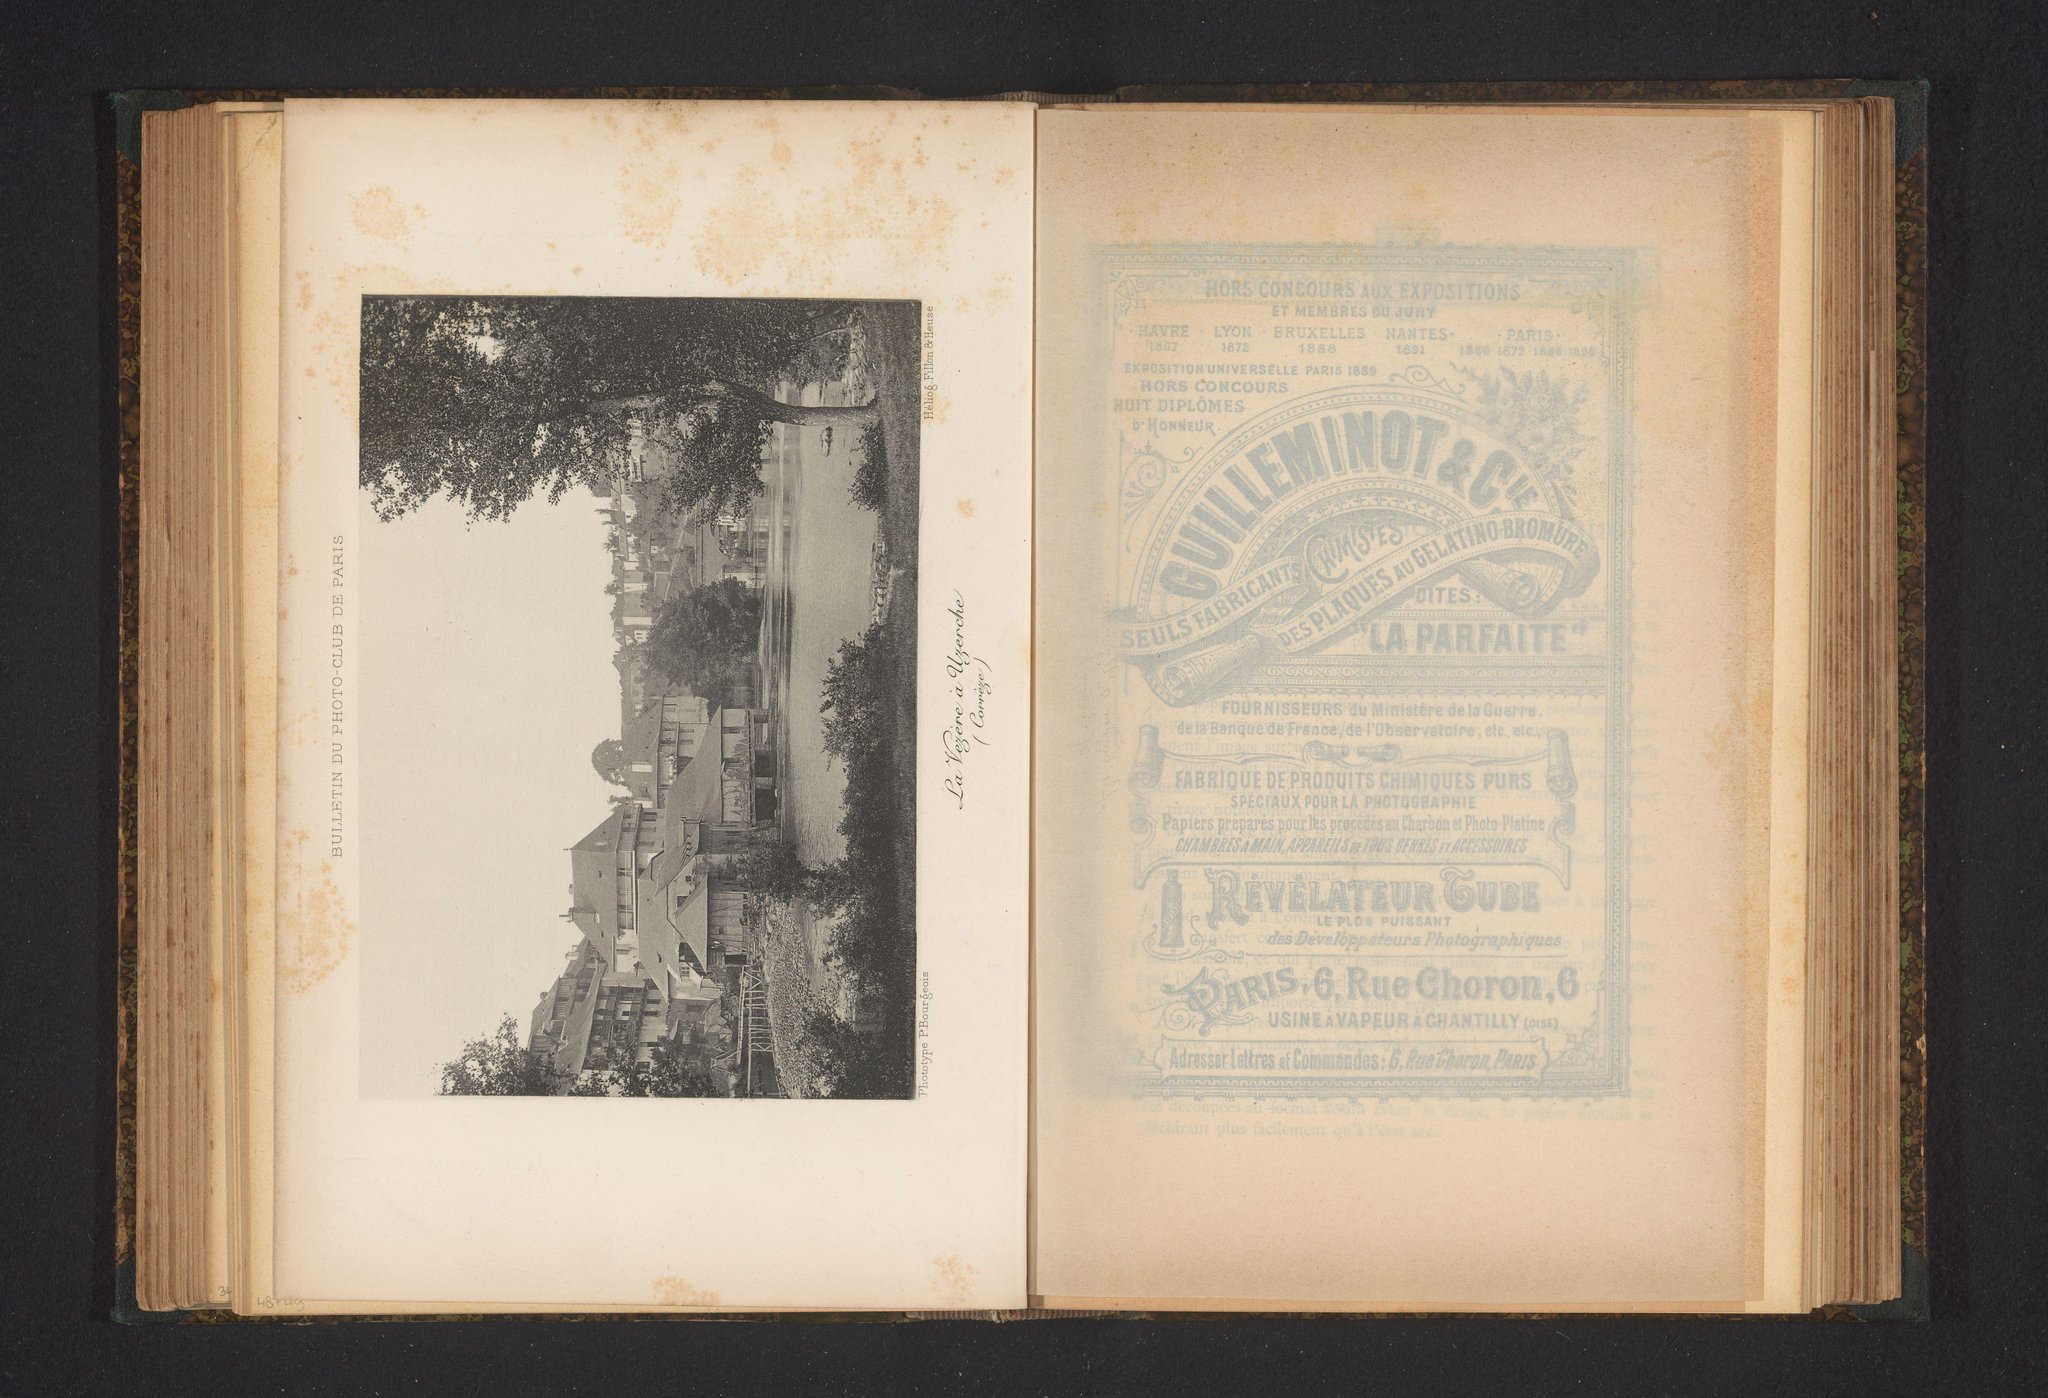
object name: photomechanical print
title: La Vezère à Uzerche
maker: paul bourgeois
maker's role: fotograaf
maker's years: -1929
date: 1890-1895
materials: paper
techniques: photoaquatint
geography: paris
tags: prospect of village, silhouette of village, river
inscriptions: inscription: ‘Bulletin du Photo-Club de Paris’